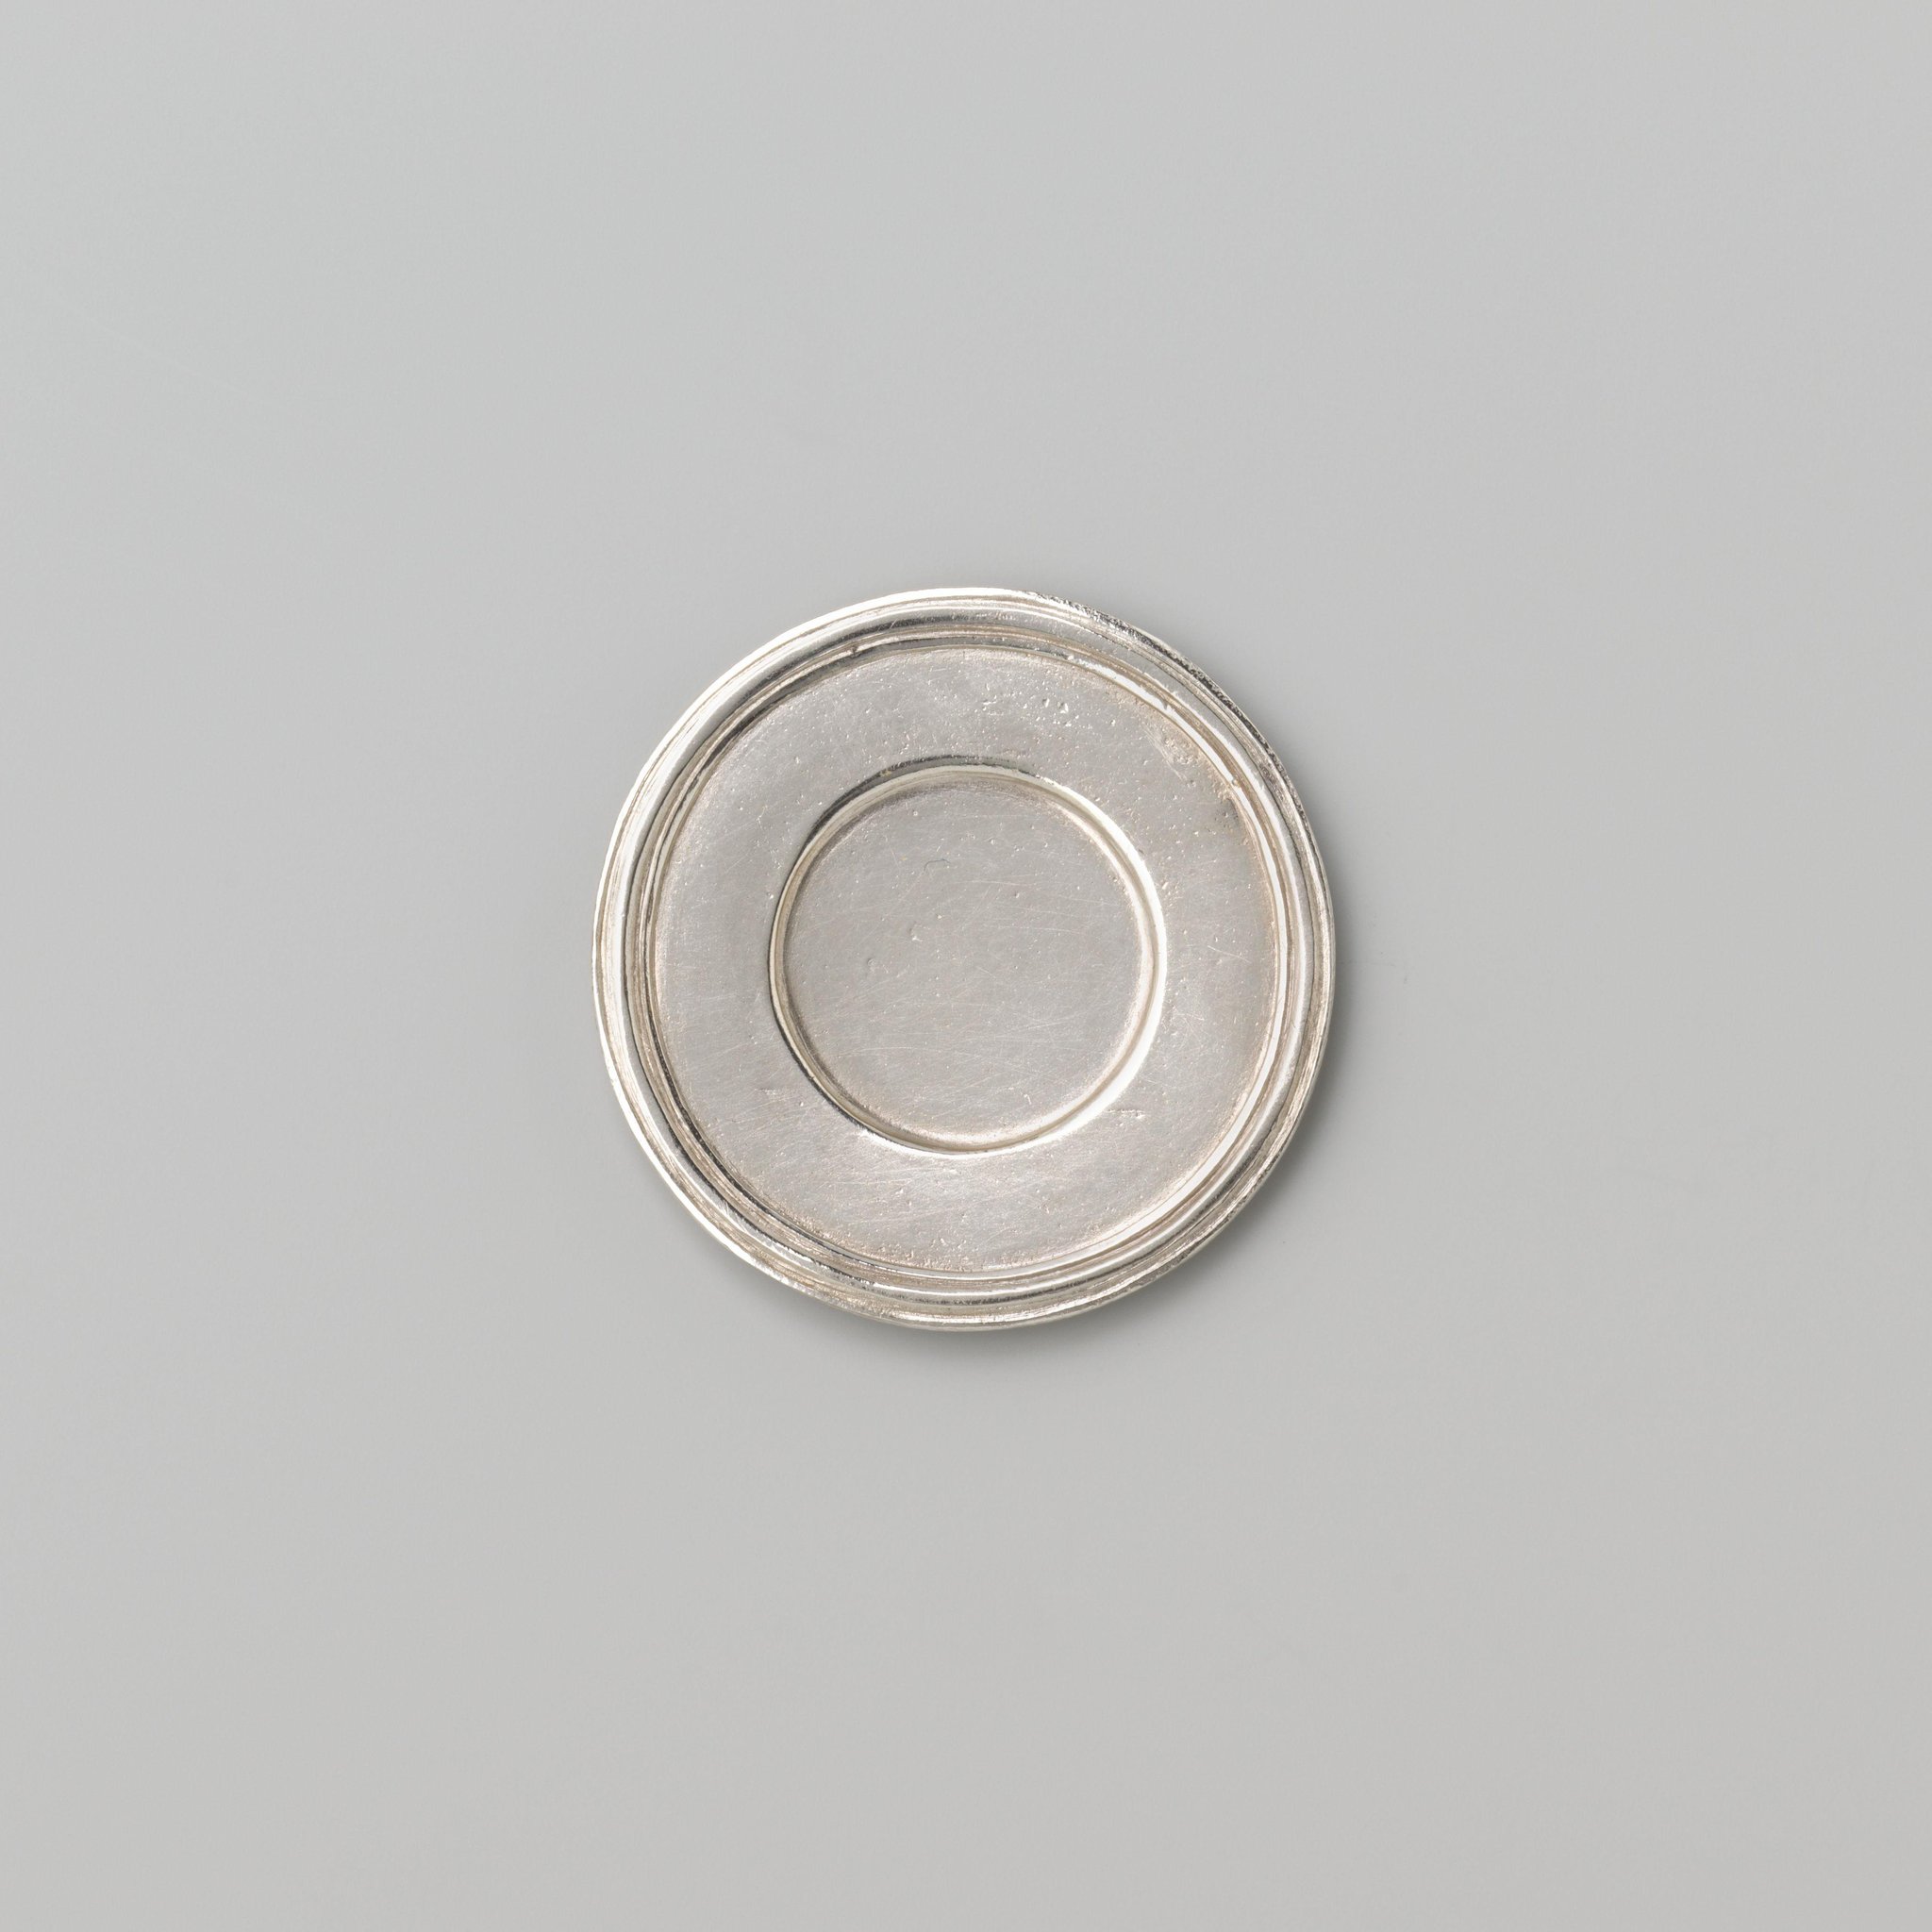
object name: miniature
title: Zilverkleurige schoteltje met brede platte geprofileerde rand.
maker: Anonymous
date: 1700-1710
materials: copper alloy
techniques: silvering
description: Zilverkleurige schotel met brede, platte geprofileerde rand.